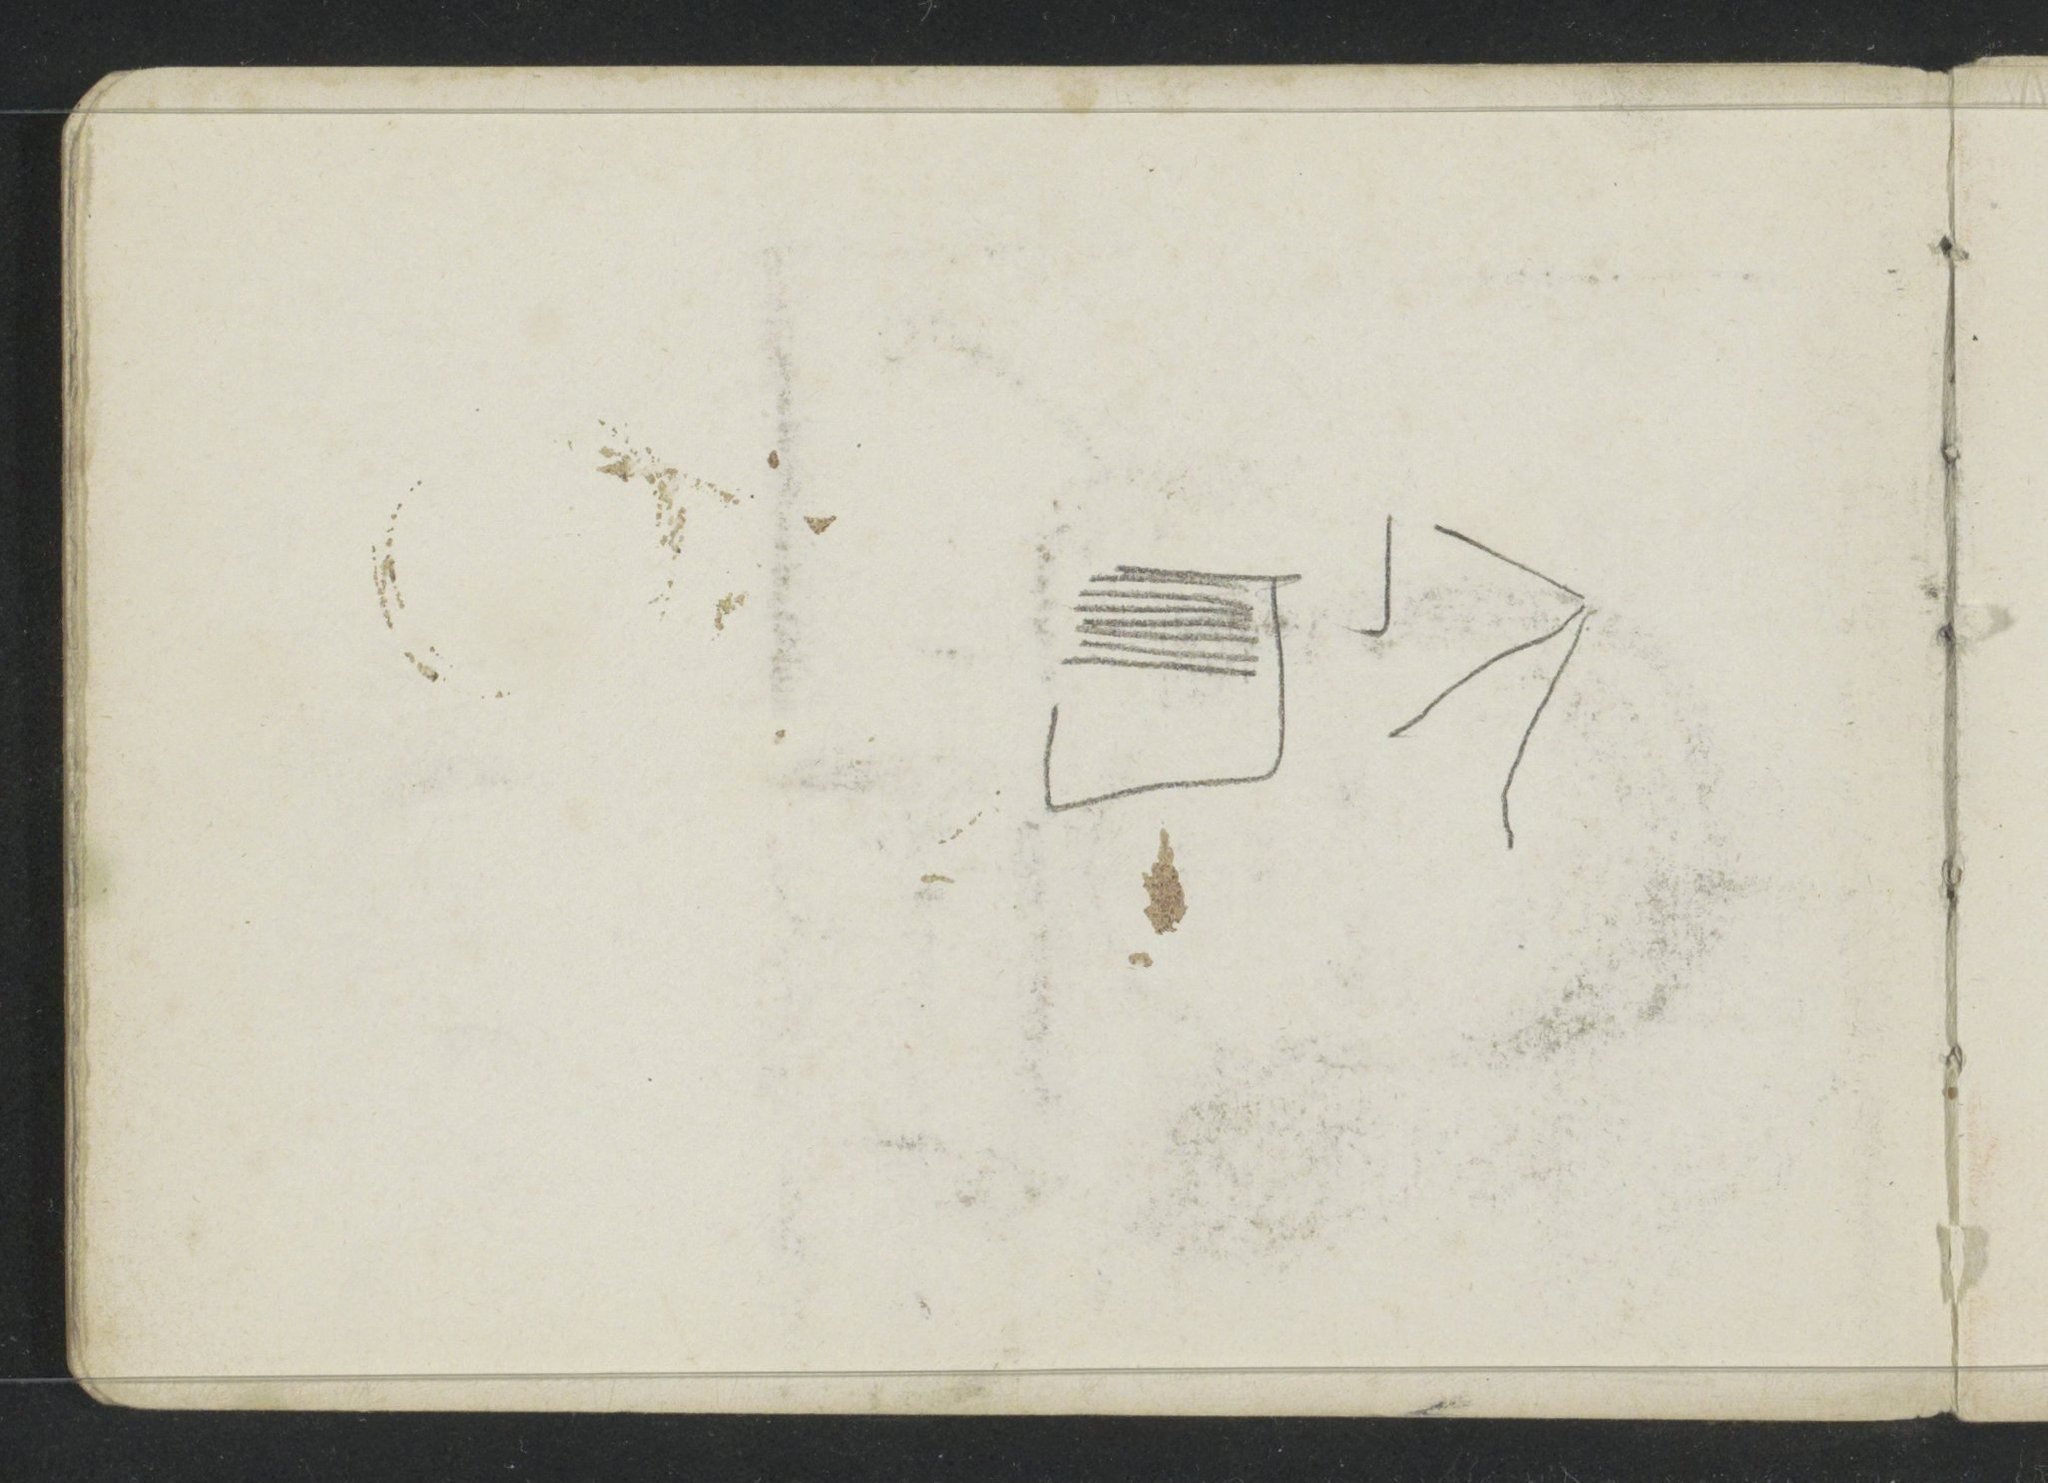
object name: sketchbook leaf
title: Studies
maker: johanna van de kamer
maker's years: 1873-1922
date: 1883-1922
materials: chalk, paper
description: Blad 1 verso uit een schetsboek met 27 bladen.